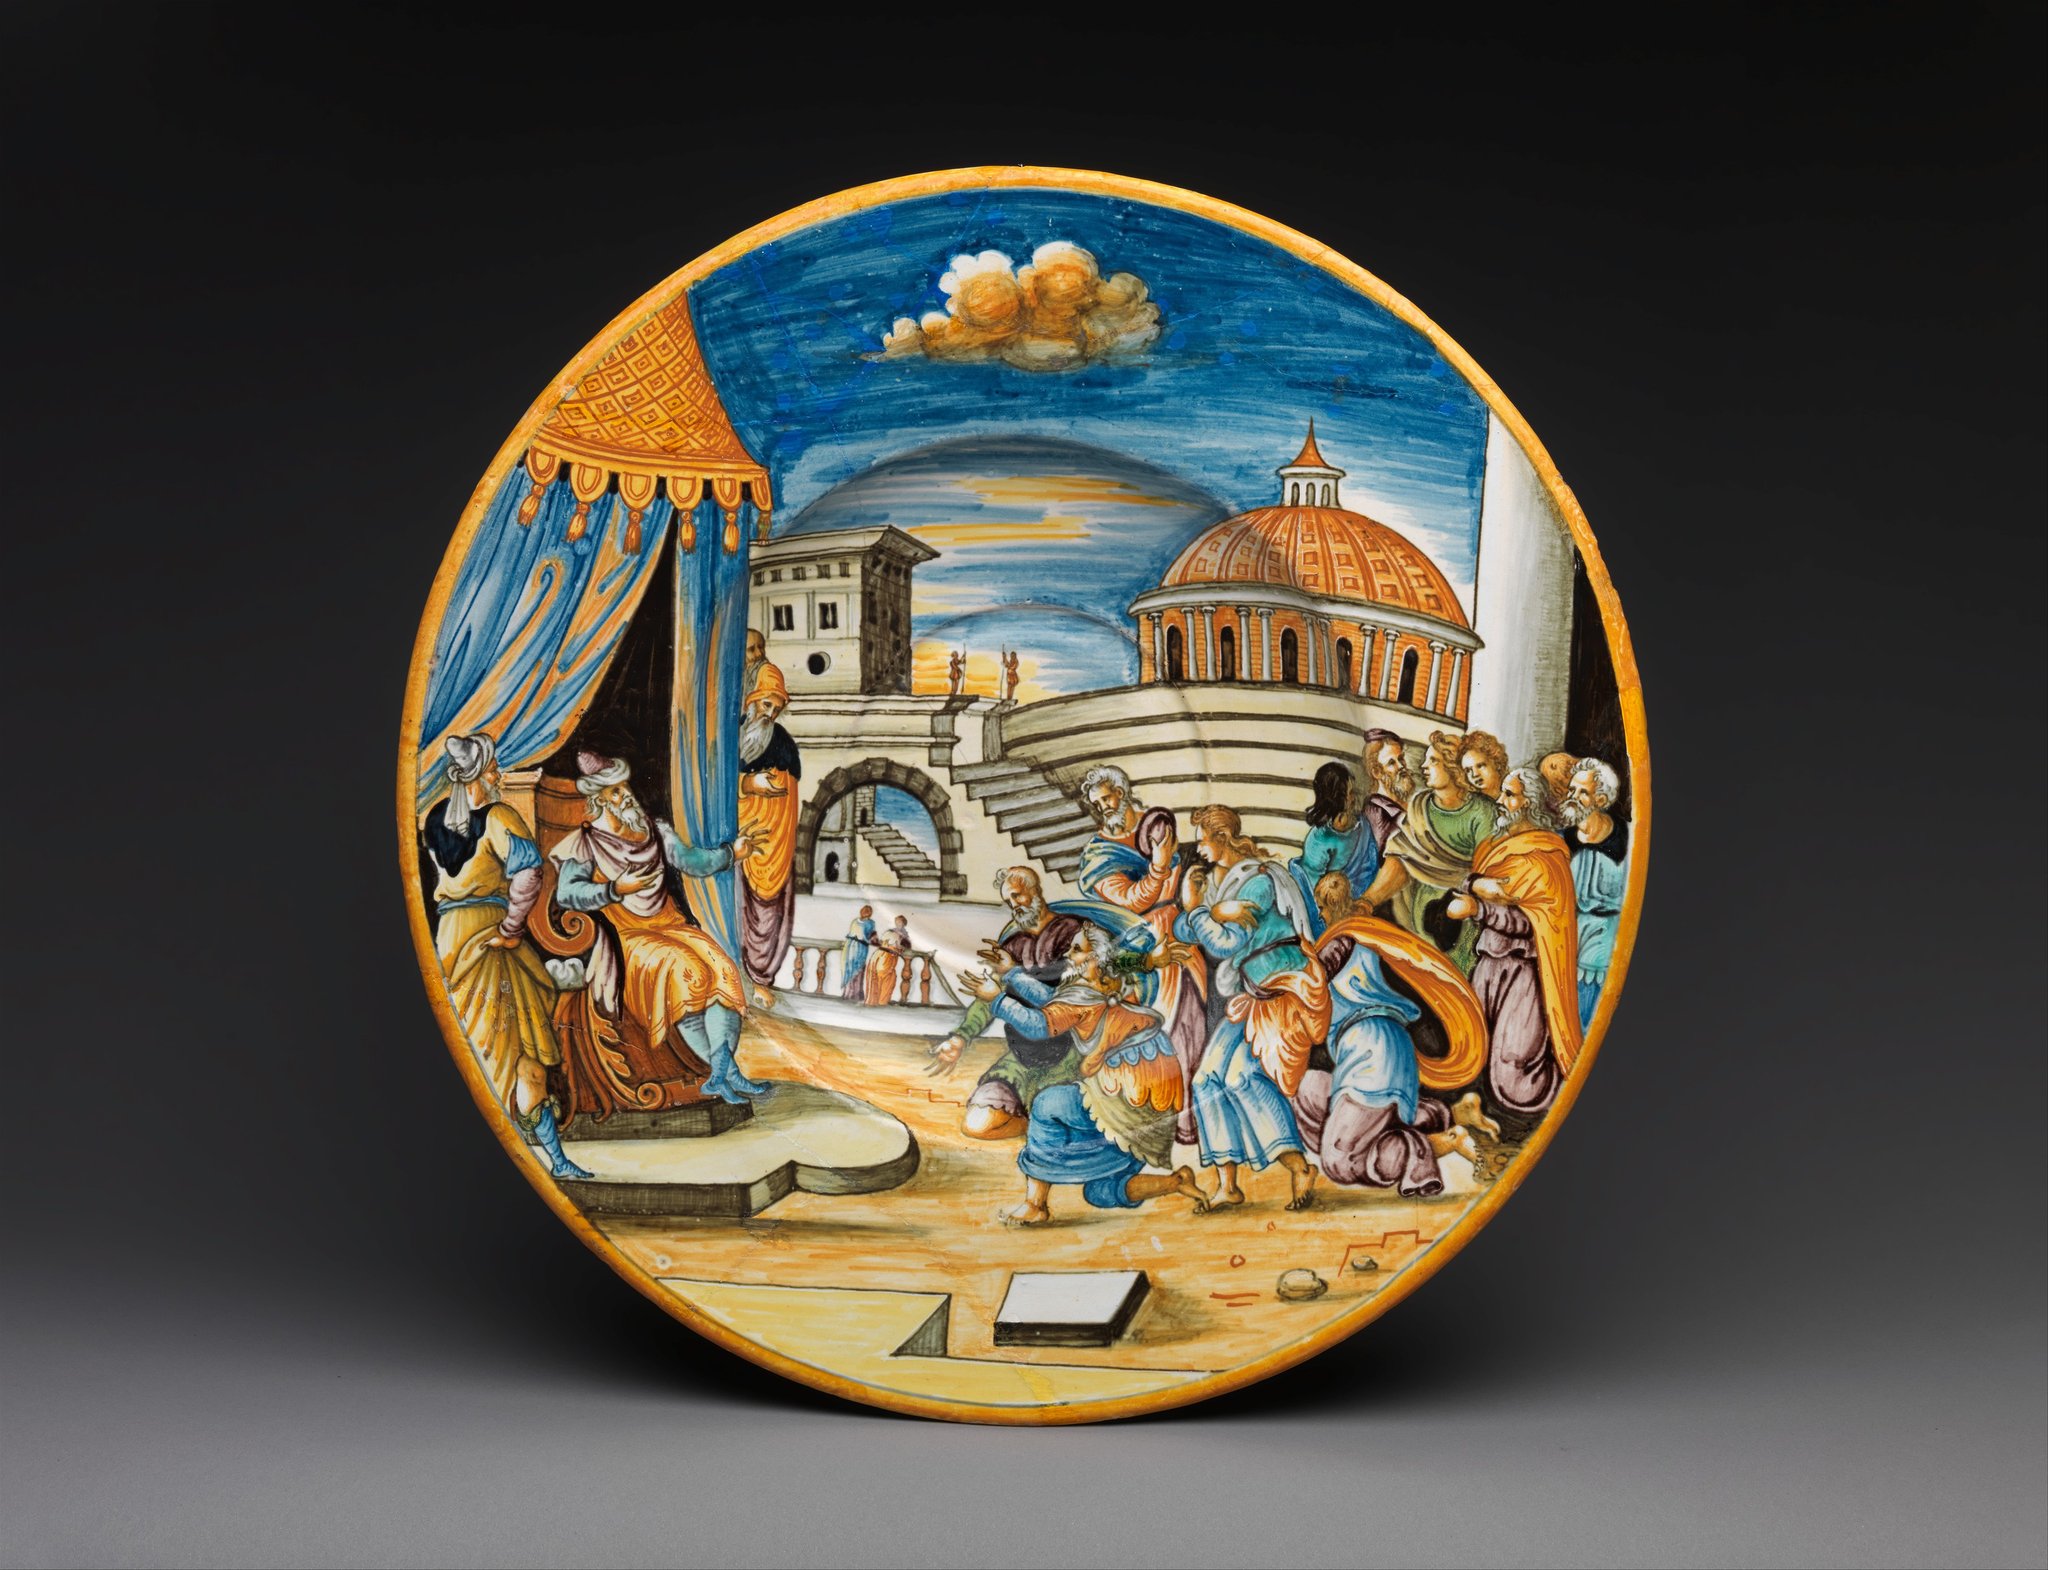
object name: dish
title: Dish with Joseph and His Brothers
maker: antoine conrade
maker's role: maker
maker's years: 1600-1700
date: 1630-1645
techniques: glazing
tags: buildings,crowd